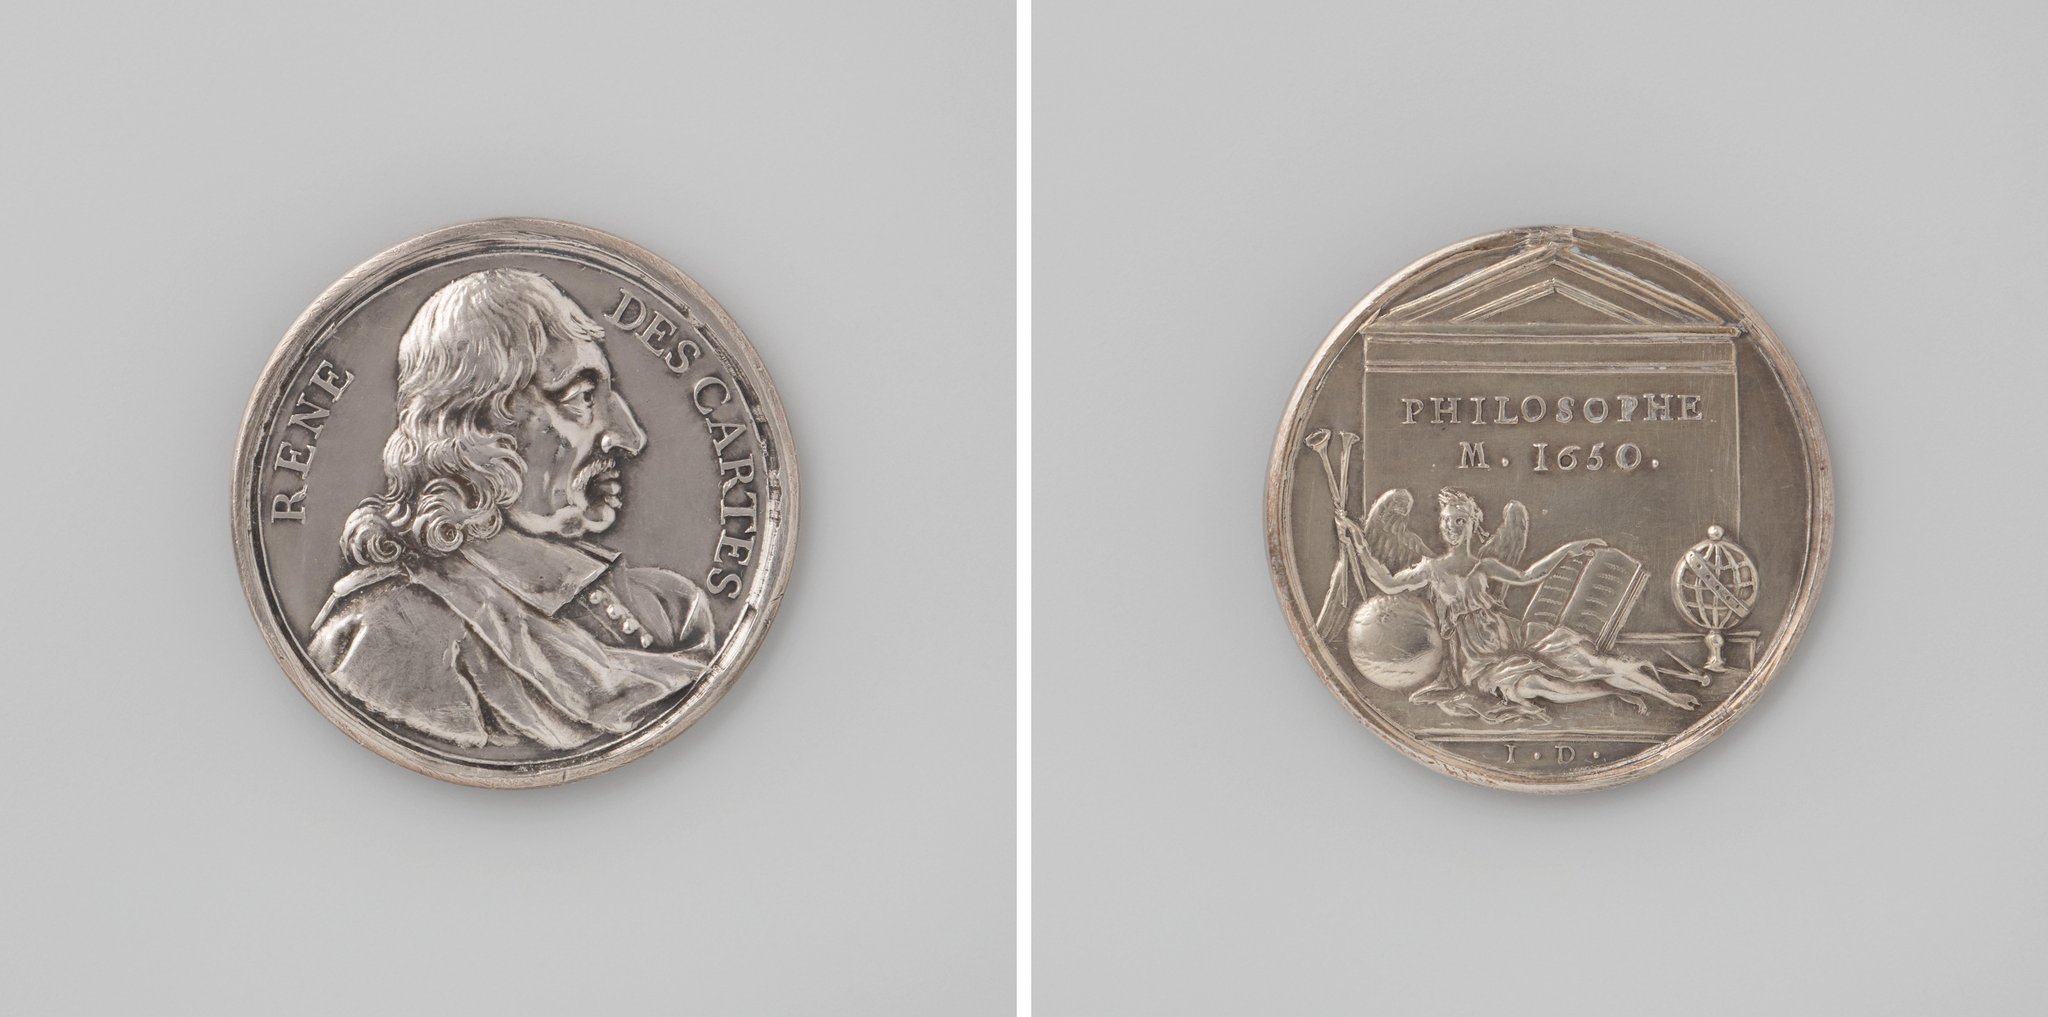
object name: history medal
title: Dood van Rene Descartes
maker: jean dassier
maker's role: medailleur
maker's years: 1676-1763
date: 1740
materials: silver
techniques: striking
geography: geneva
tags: rené descartes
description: Zilveren penning. Voorzijde: borststuk man binnen omschrift. Keerzijde: Faam met twee bazuinen, open boek en twee globes gezeten voor grafmonument